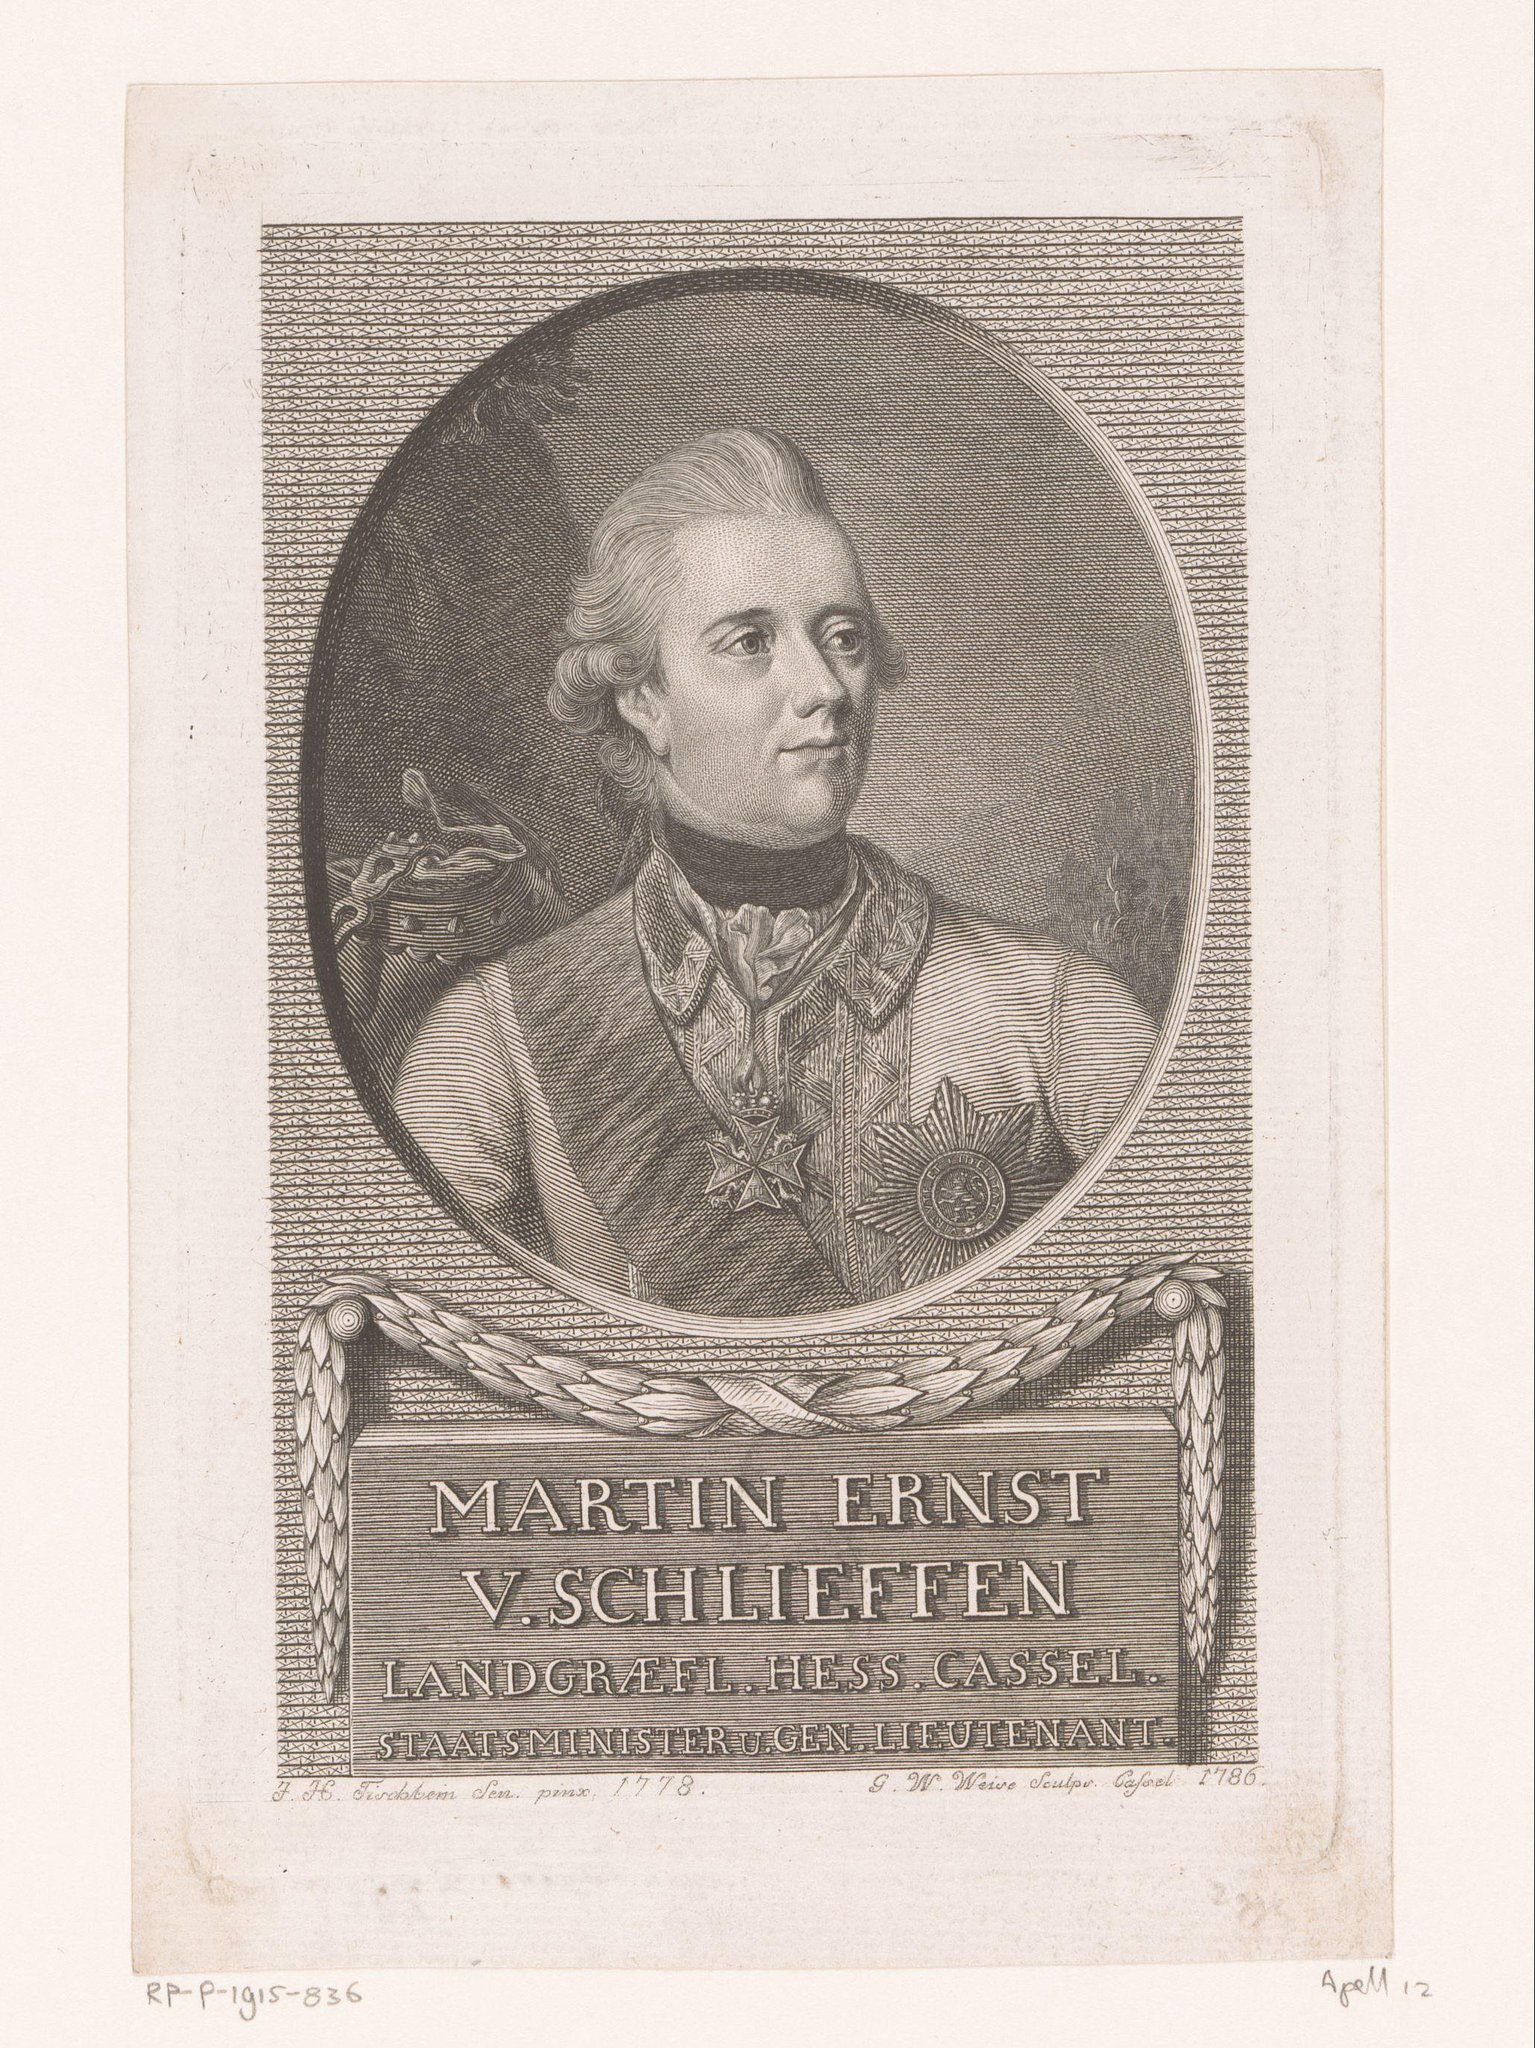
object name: print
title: Portret van Martin Ernst von Schlieffen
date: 1786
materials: paper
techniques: engraving, etching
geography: germany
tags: knighthood order, historical persons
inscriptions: collector's mark: Lugt 2228